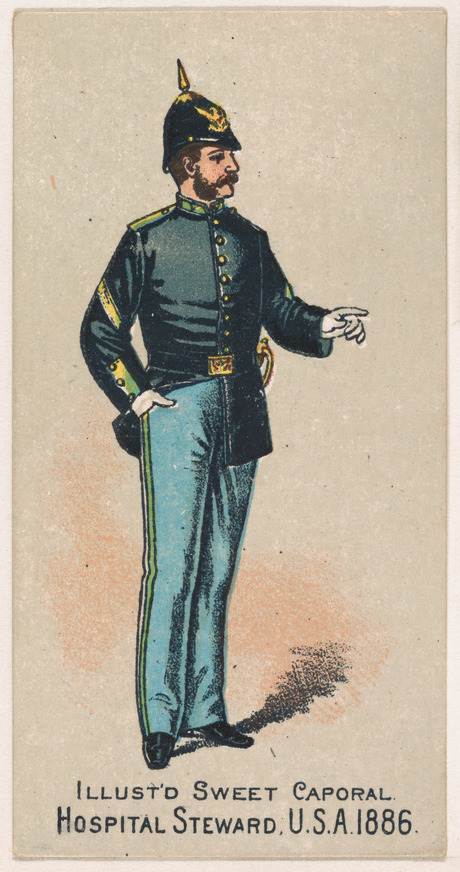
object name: print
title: Hospital Steward, United States Army, 1886, from the Military Series (N224) issued by Kinney Tobacco Company to promote Sweet Caporal Cigarettes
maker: kinney brothers tobacco company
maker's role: publisher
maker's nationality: american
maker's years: 1869-2011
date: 1888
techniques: color lithograph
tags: men,profiles